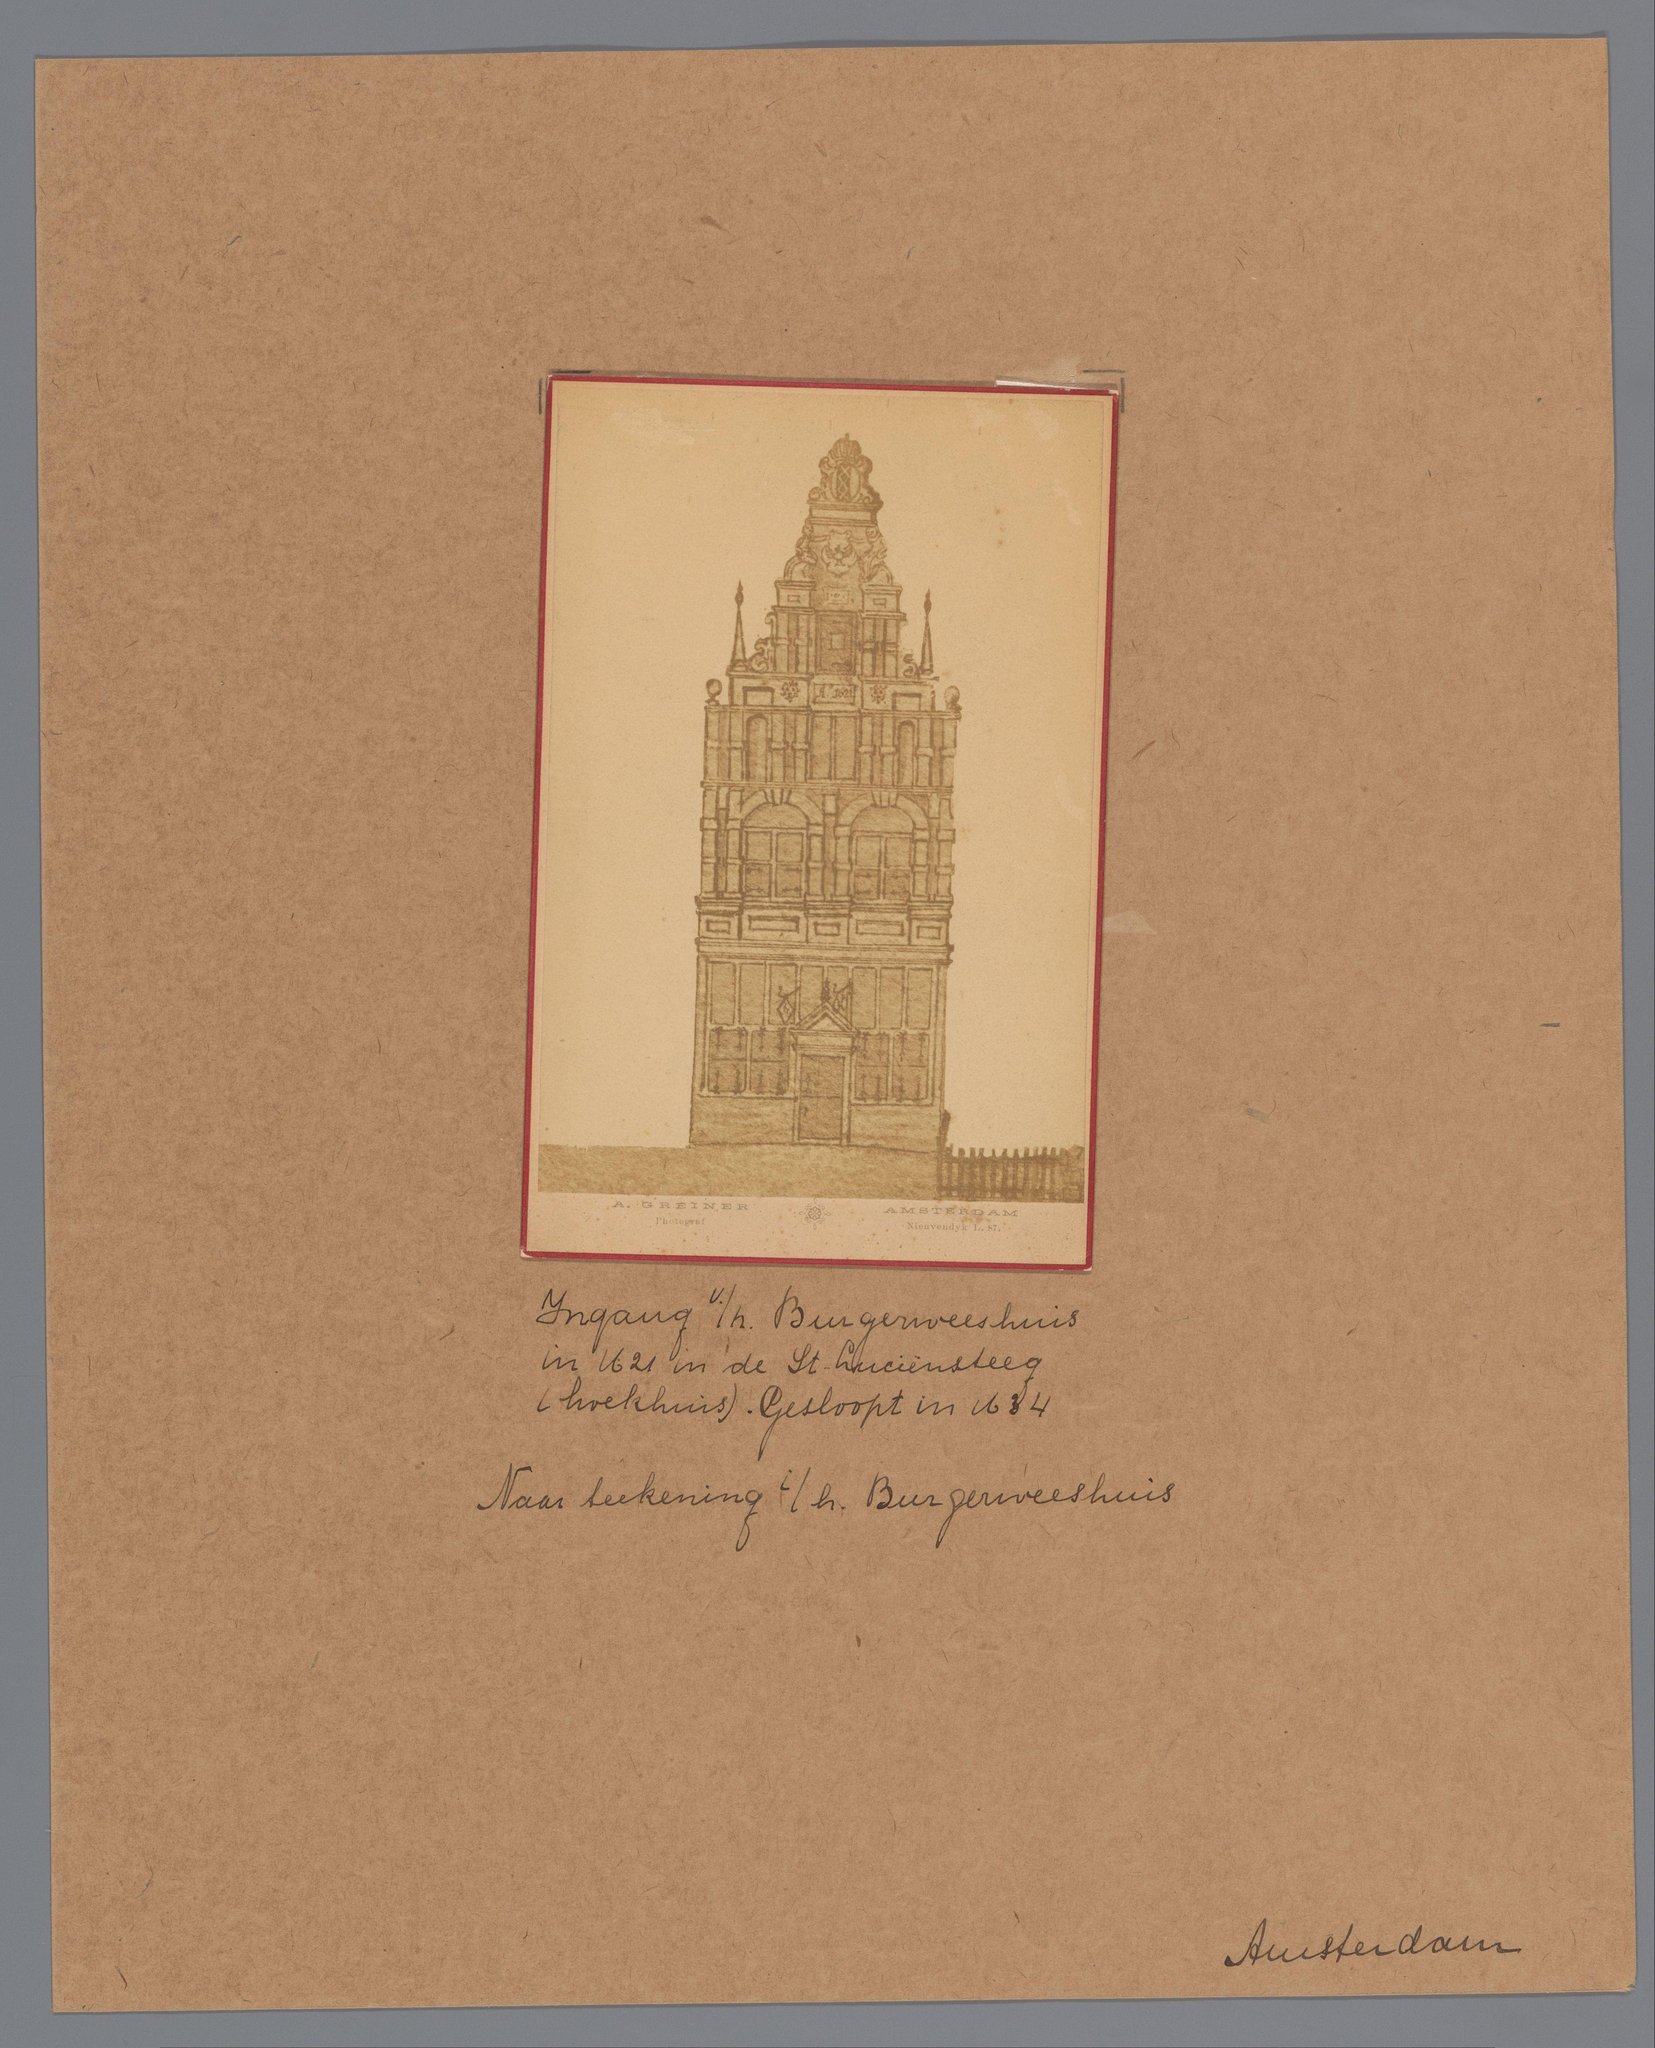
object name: photograph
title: Fotoreproductie van een tekening van de voorgevel van het Burgerweeshuis te Amsterdam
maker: albert greiner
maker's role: fotograaf, fotostudio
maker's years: 1833-1890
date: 1861-1874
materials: cardboard, photographic support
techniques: albumen print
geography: amsterdam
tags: drawing, sketch, façade (of house or building)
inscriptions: annotation: ‘Ingang van het Burgerweeshuis in/ 1621 in de St-luciënsteeg (hoekhuis)./ Gesloopt in 1634/ Naar teekening in het Burgerweeshuis’, annotation: ‘Ingang v/h Burgerweeshuis/ in 1621 in de St-luciënsteeg/ (hoekhuis). Gesloopt in 1634/ Naar teekening i/h Burgerweeshuis/ Amsterdam’